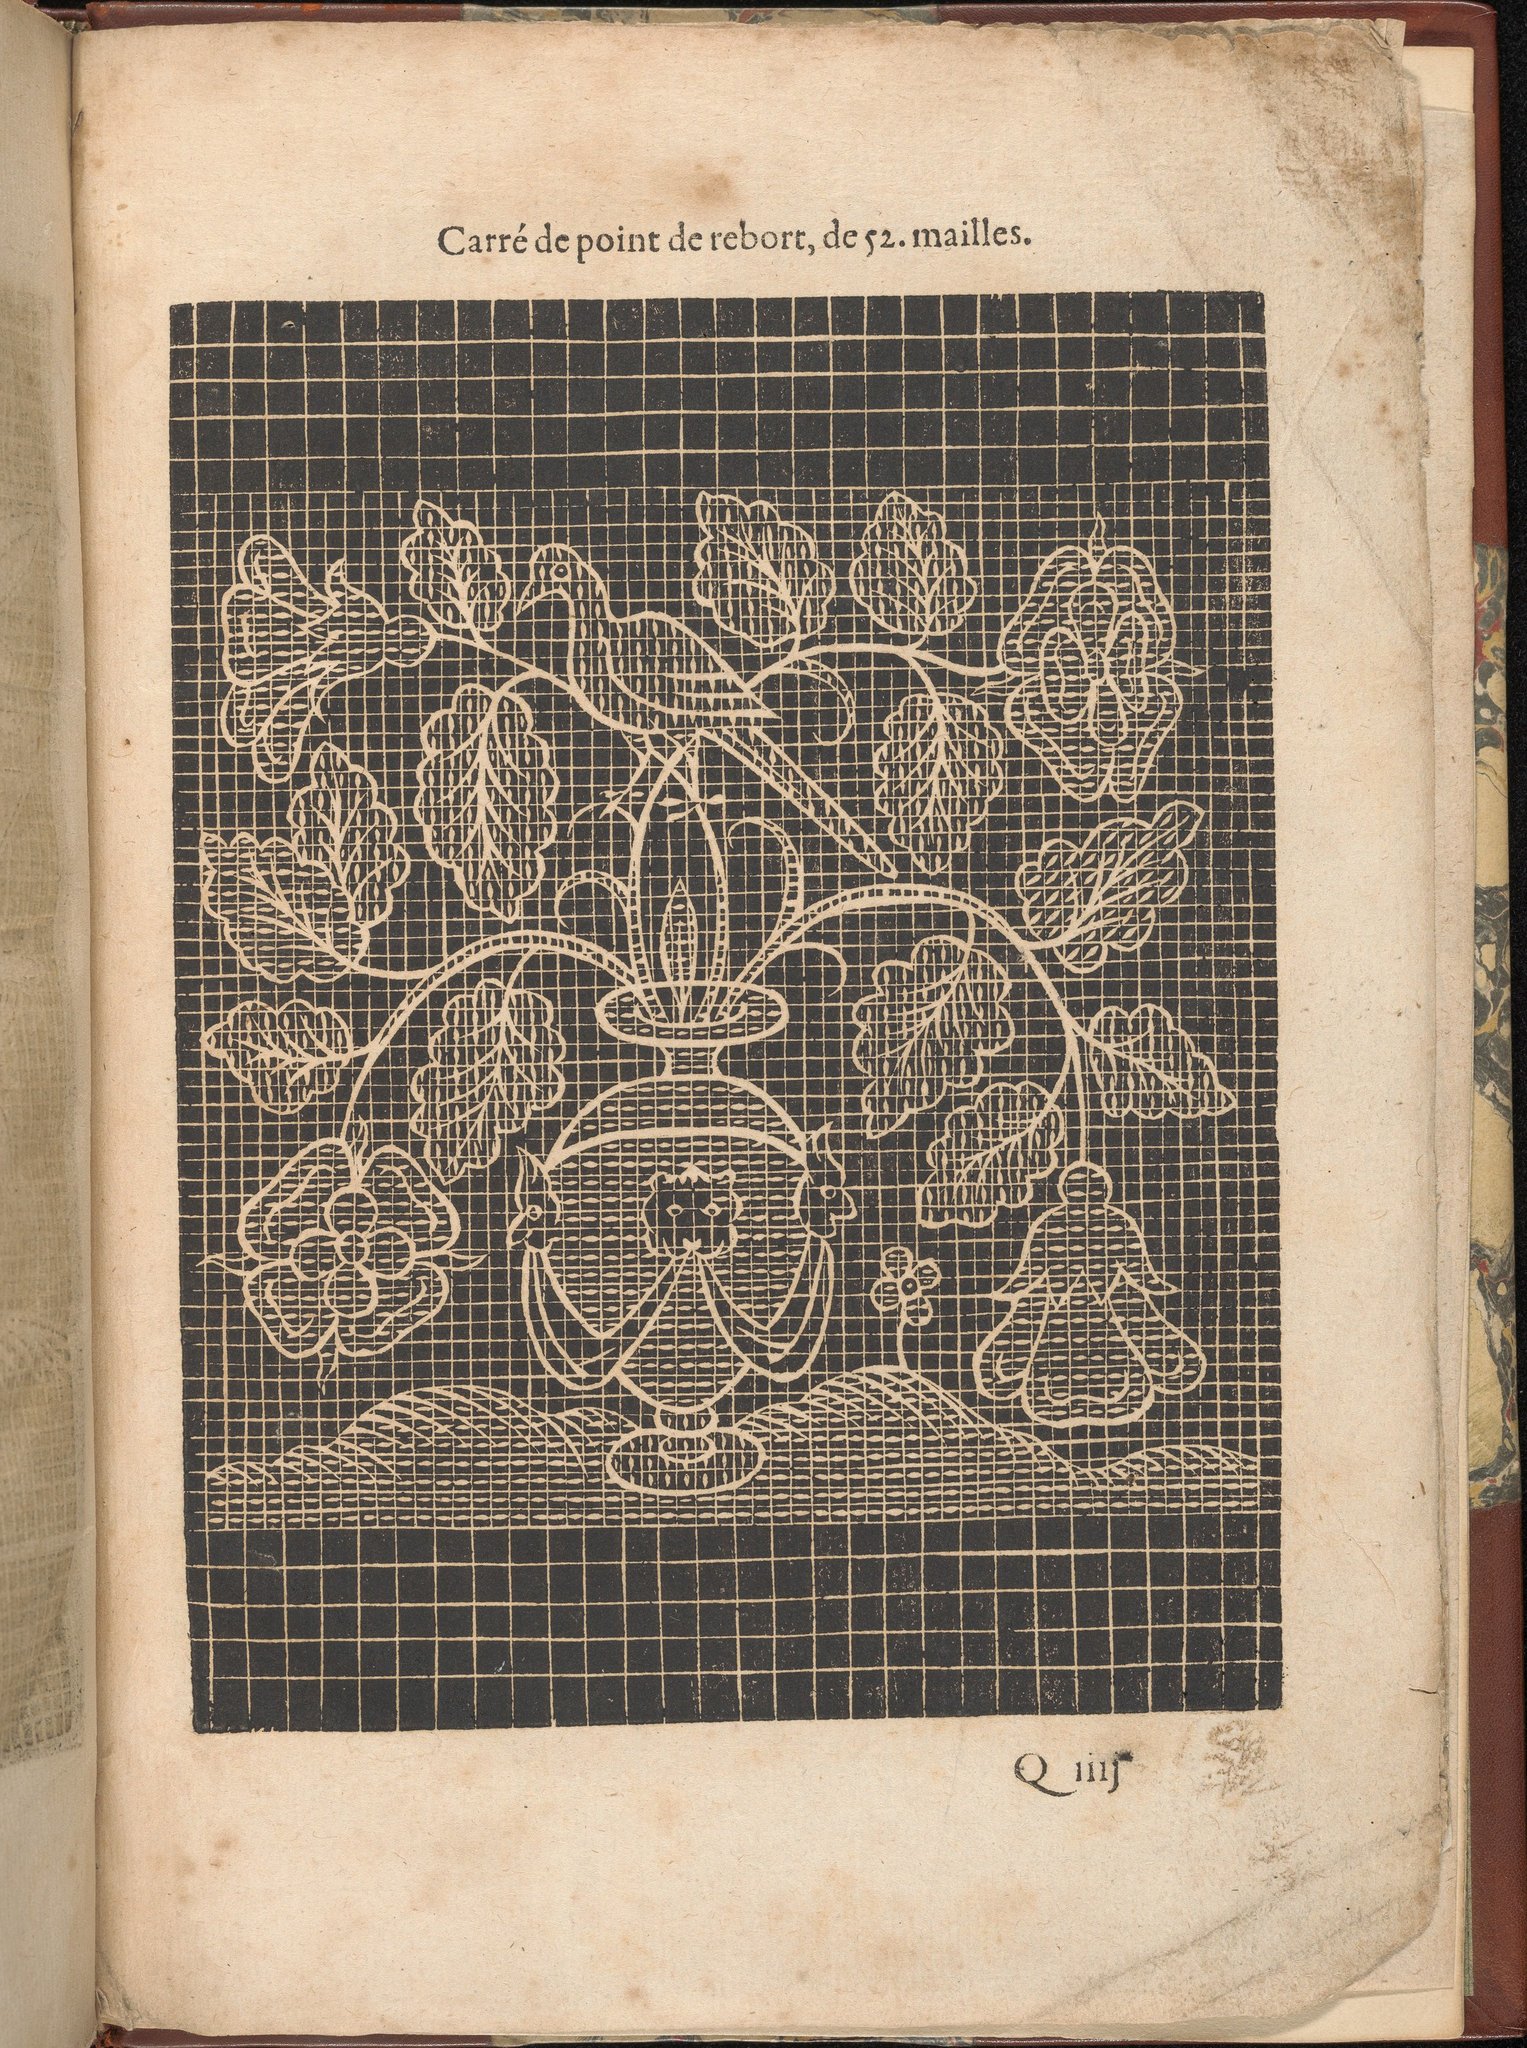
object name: book print ornament architecture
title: Les Secondes Oeuvres, et Subtiles Inventions De Lingerie du Seigneur Federic de Vinciolo Venitien, page 64 (recto)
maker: federico de vinciolo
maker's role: designer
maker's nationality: italian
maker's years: 1582-1599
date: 1603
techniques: woodcut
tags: birds,flowers,vases